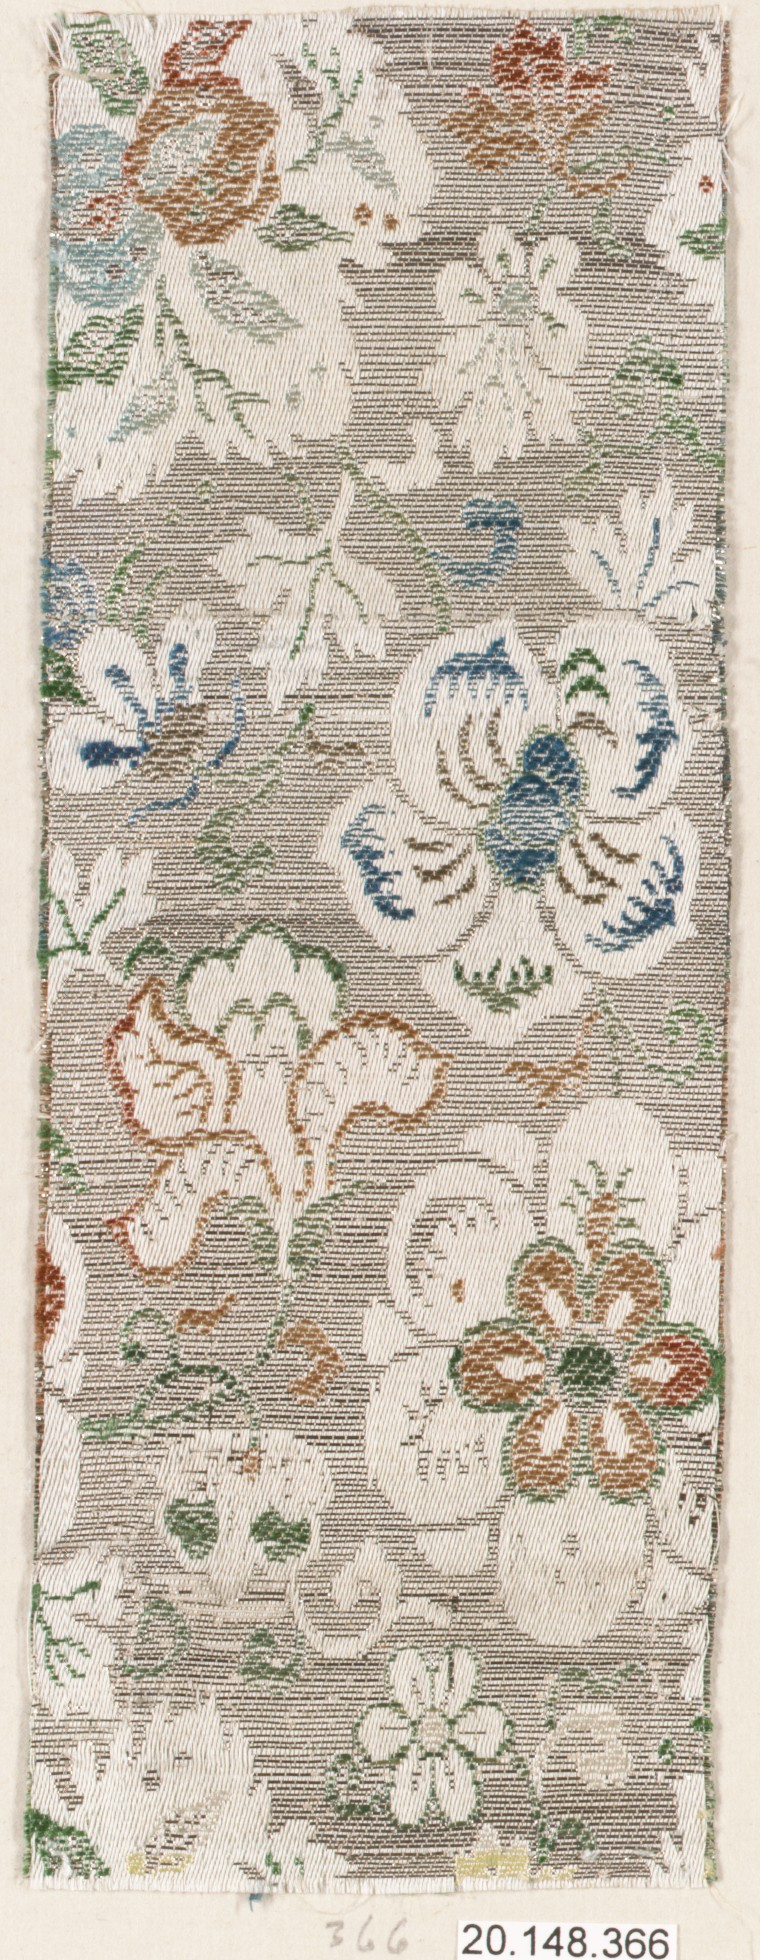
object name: piece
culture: japanese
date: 1701-1800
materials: silk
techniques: compound weave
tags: flowers